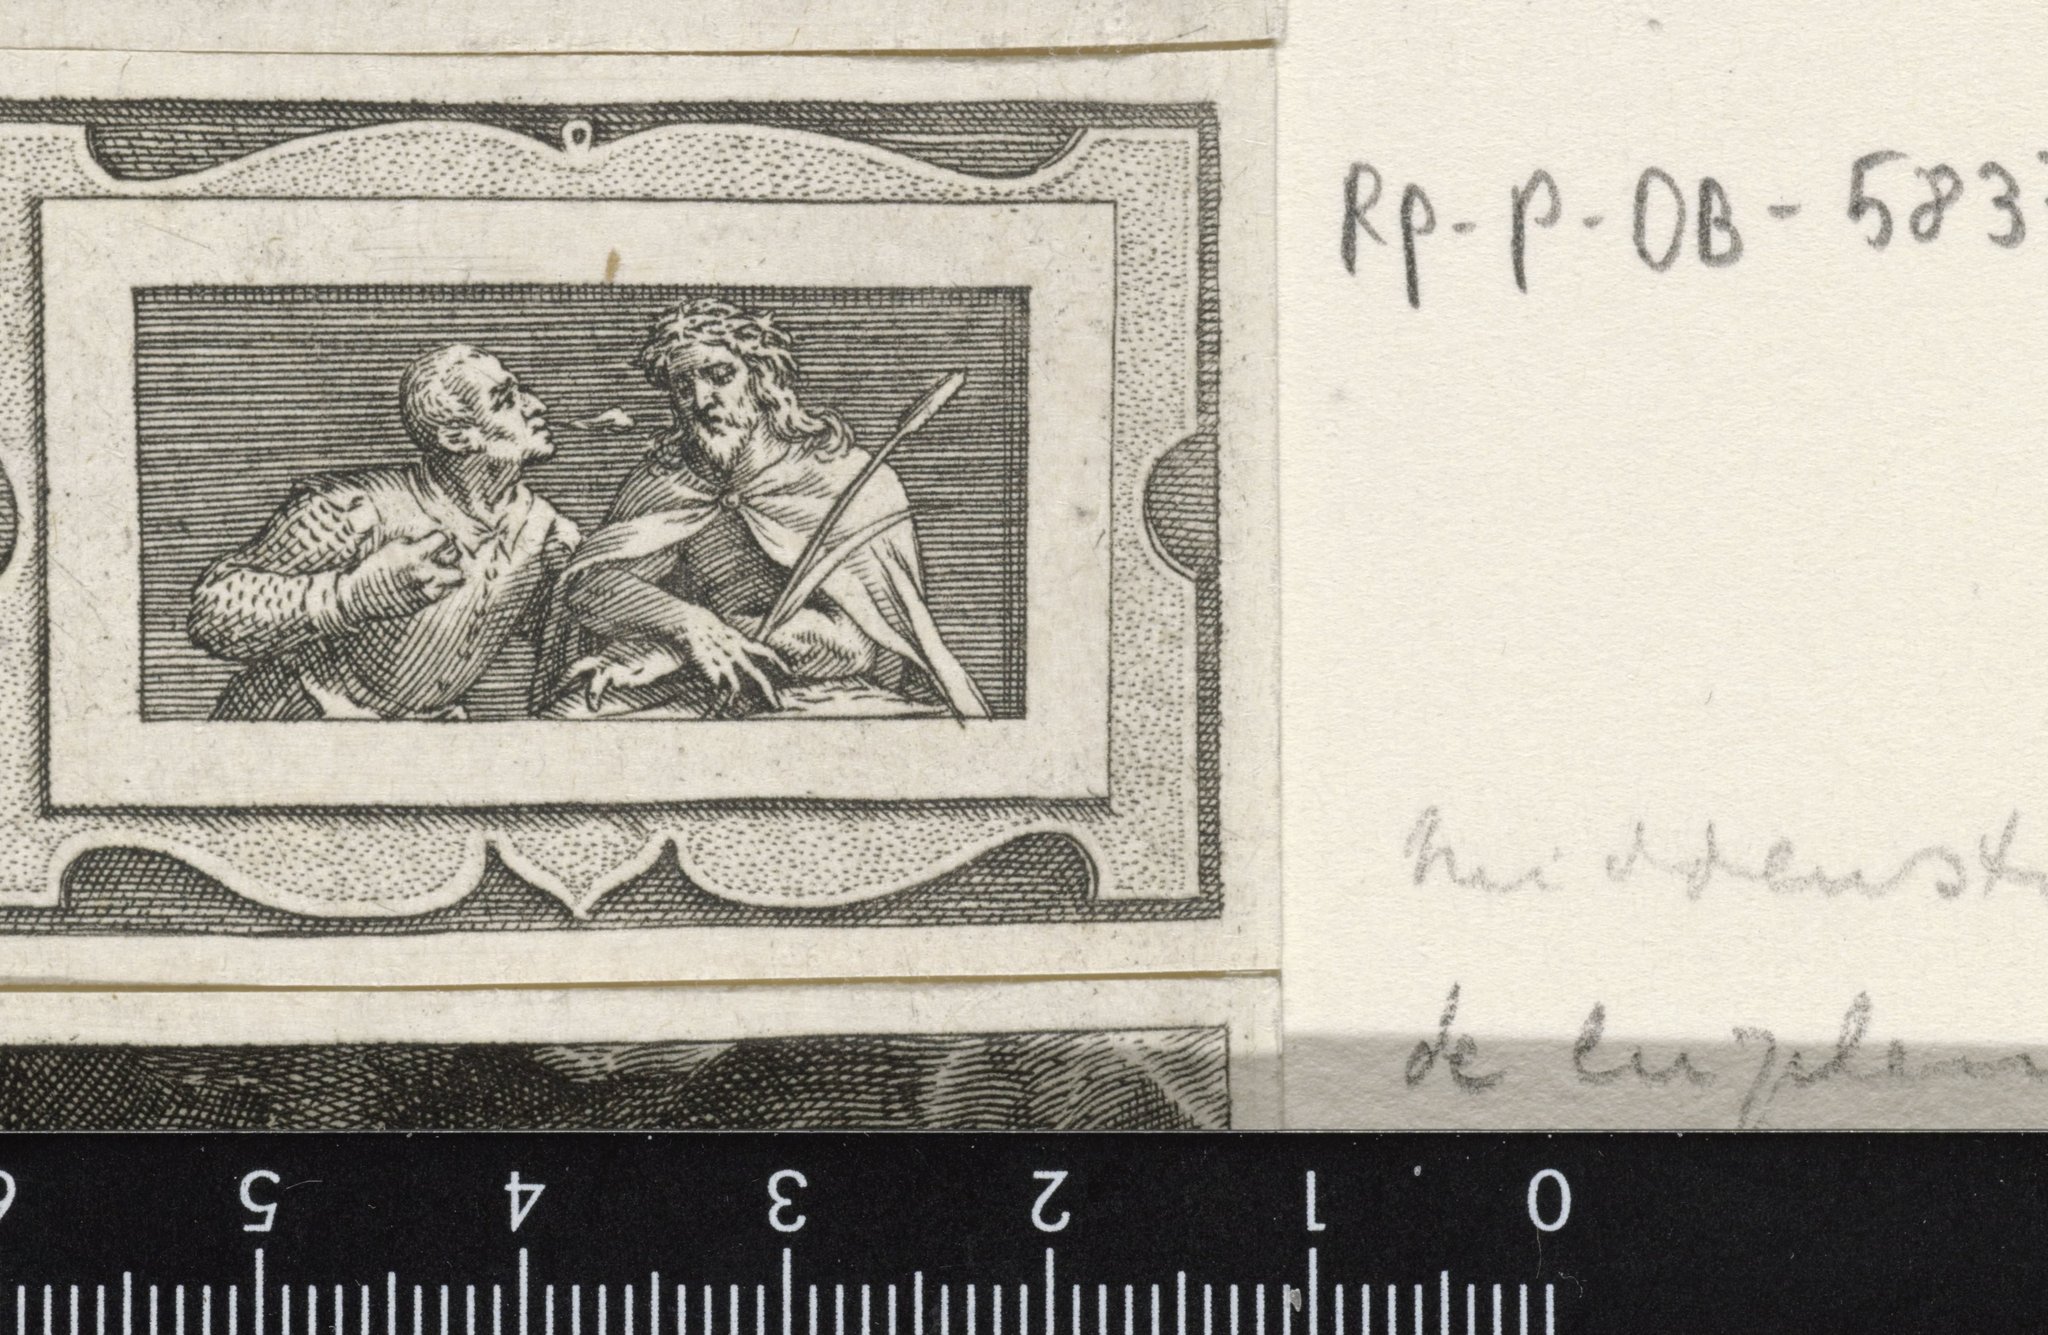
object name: print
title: Bespotting van Christus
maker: johann sadeler (i)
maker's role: print maker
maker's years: 1550-1600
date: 1580-1600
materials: paper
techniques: engraving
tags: mockings of christ, who may be blindfolded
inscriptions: collector's mark: Lugt 240